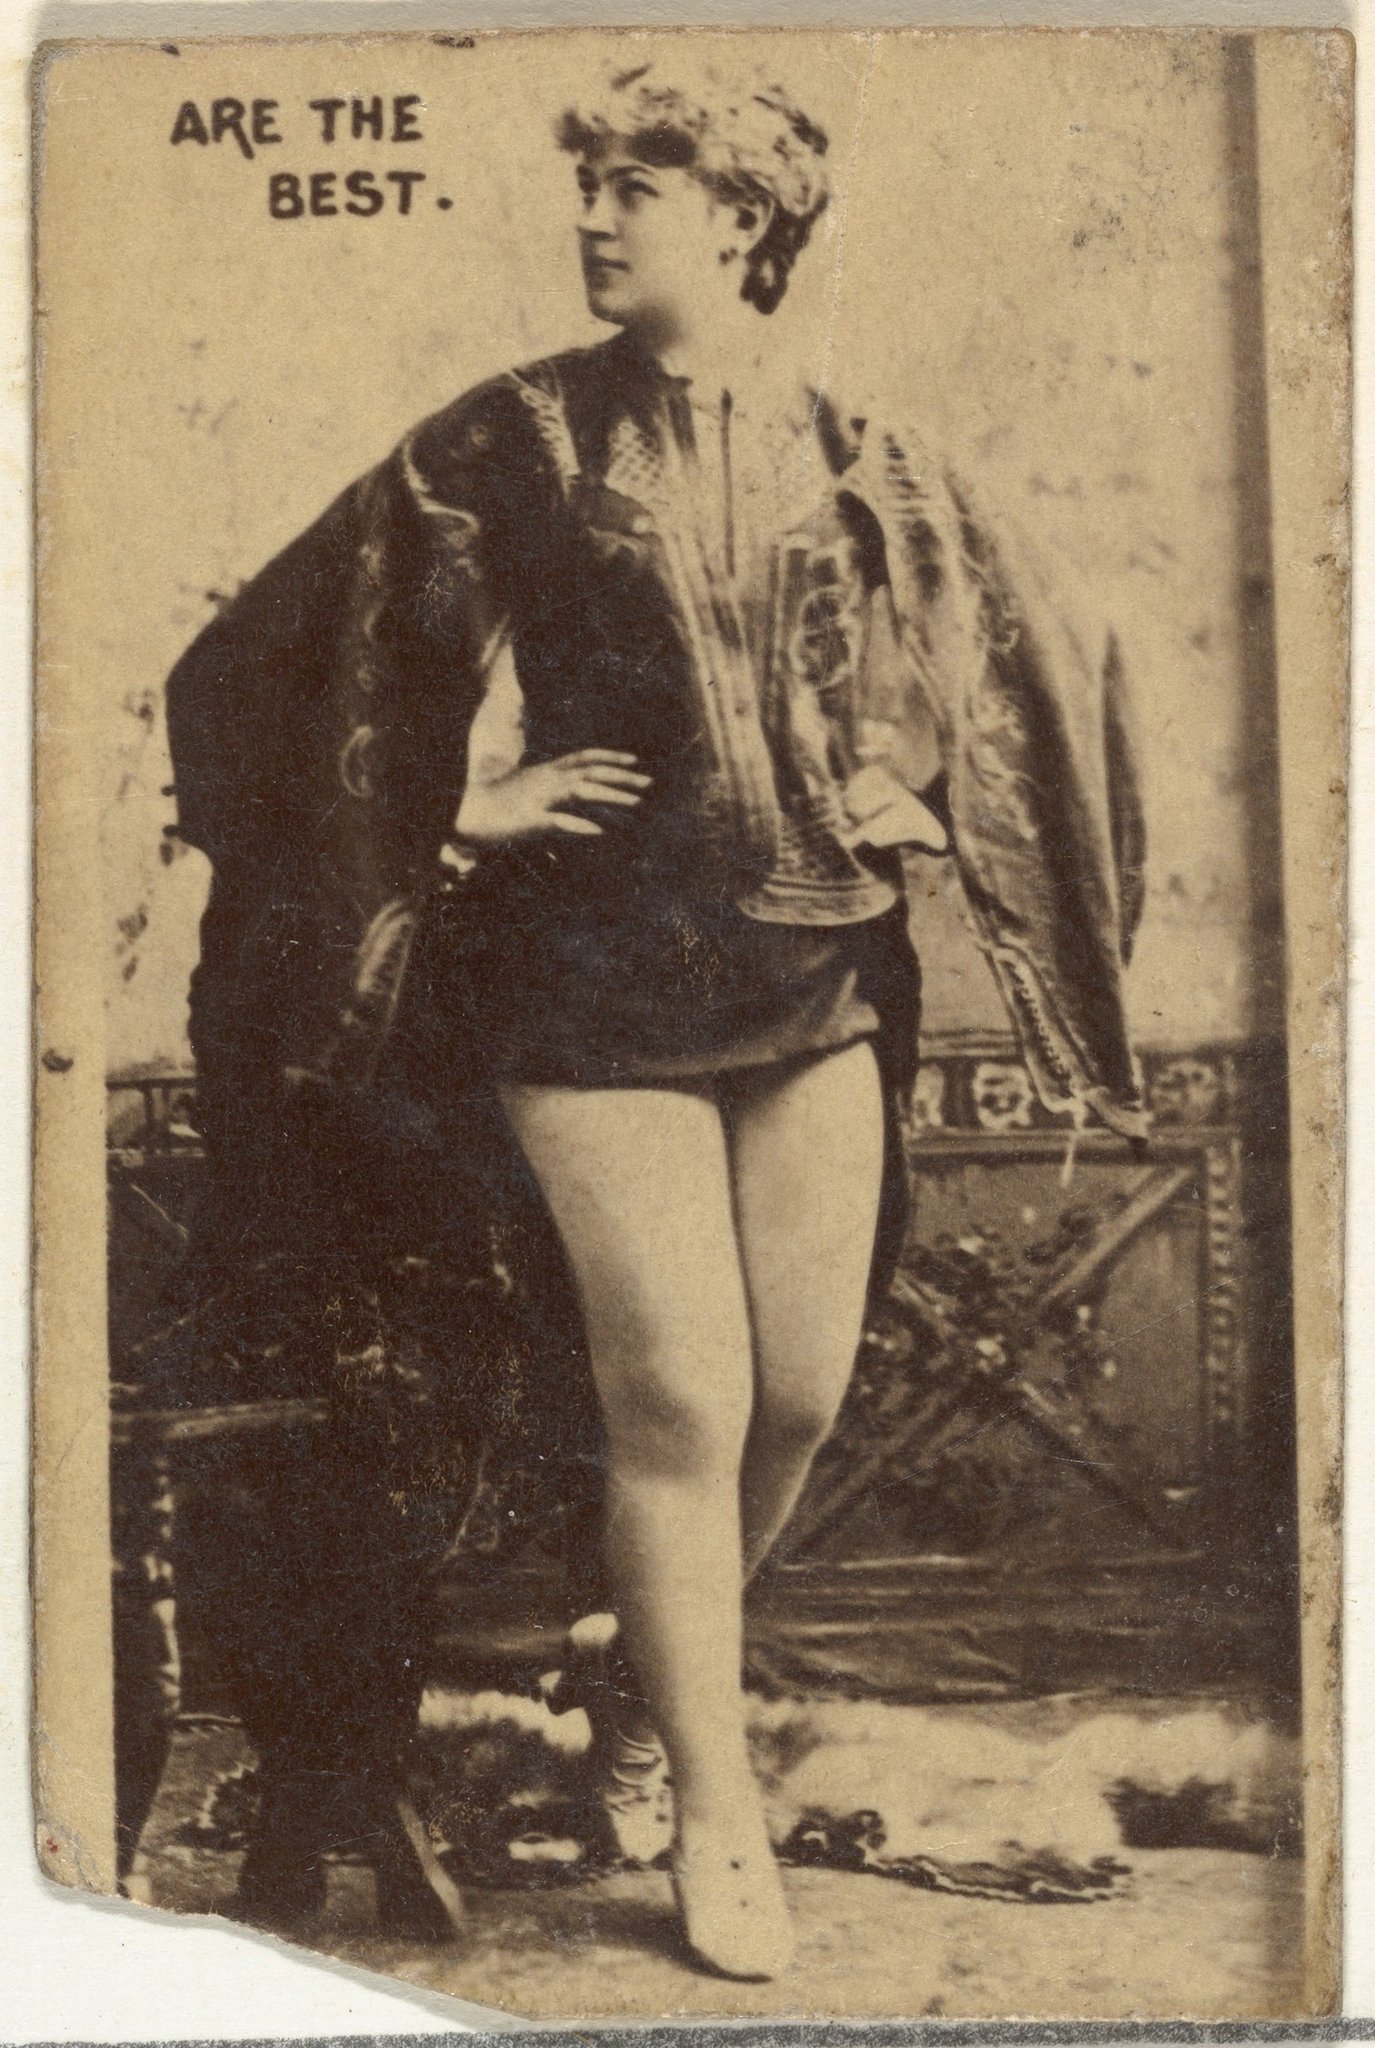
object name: photograph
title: [Actress posing with hands on hips], from the Actors and Actresses series (N145-6) issued by Duke Sons & Co. to promote Duke Cigarettes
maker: w. duke, sons & co.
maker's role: publisher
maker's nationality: american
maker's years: 1870-1920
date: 1880-1889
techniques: albumen silver print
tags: women,actresses